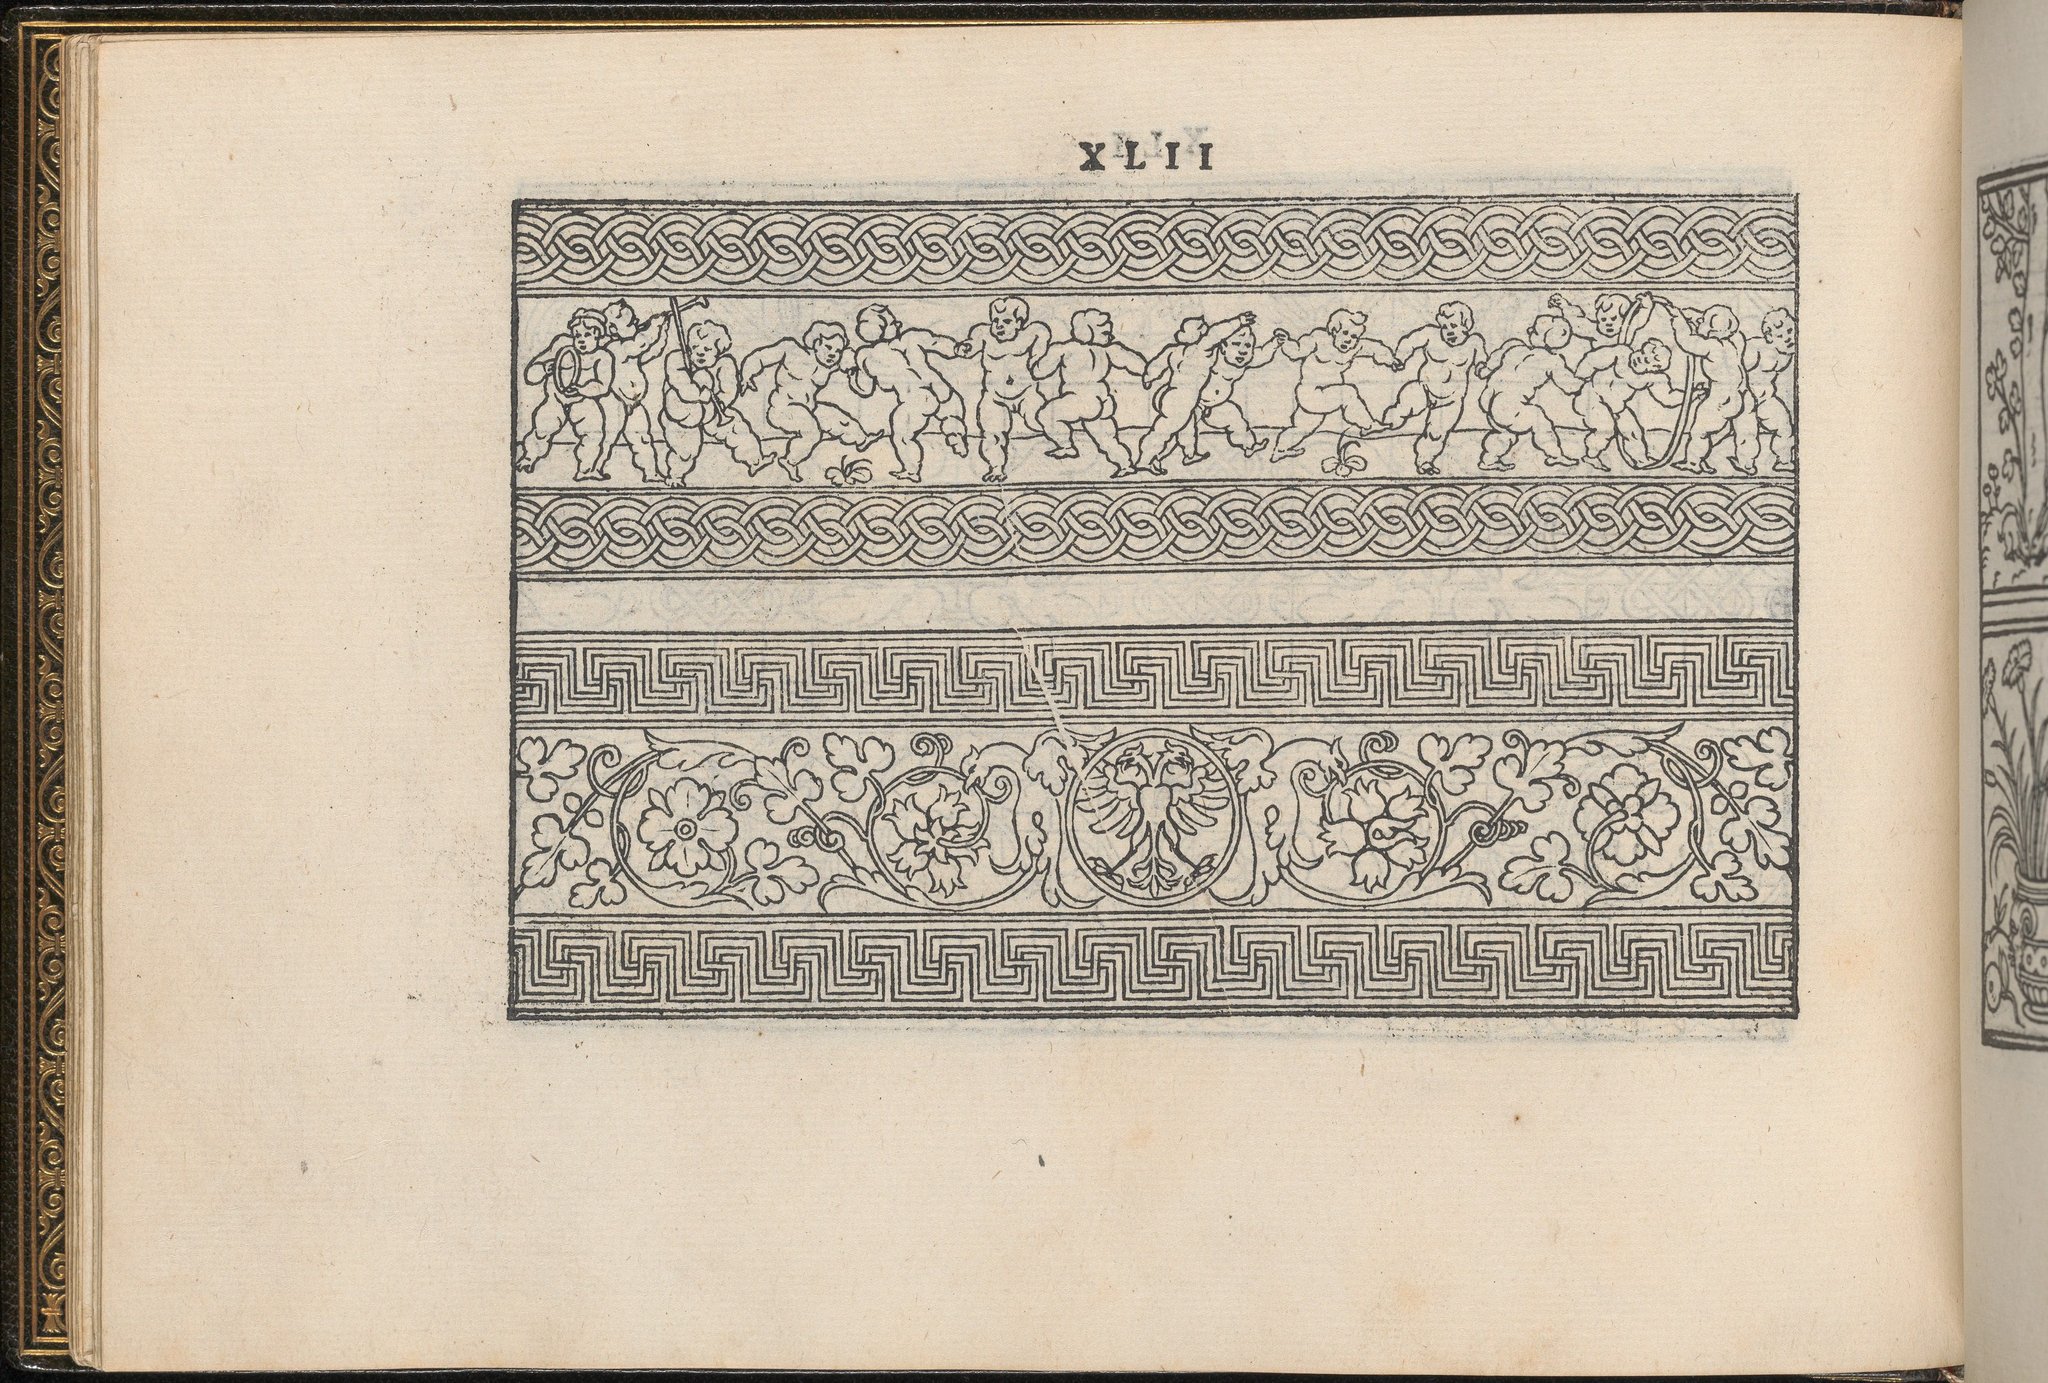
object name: book print ornament architecture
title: La Vera Perfettione del Disegno di varie sorti di recami, page 21 (verso)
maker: giovanni ostaus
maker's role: publisher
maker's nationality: italian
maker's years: 1507-1607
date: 1567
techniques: woodcut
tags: ornament,dancing,putti